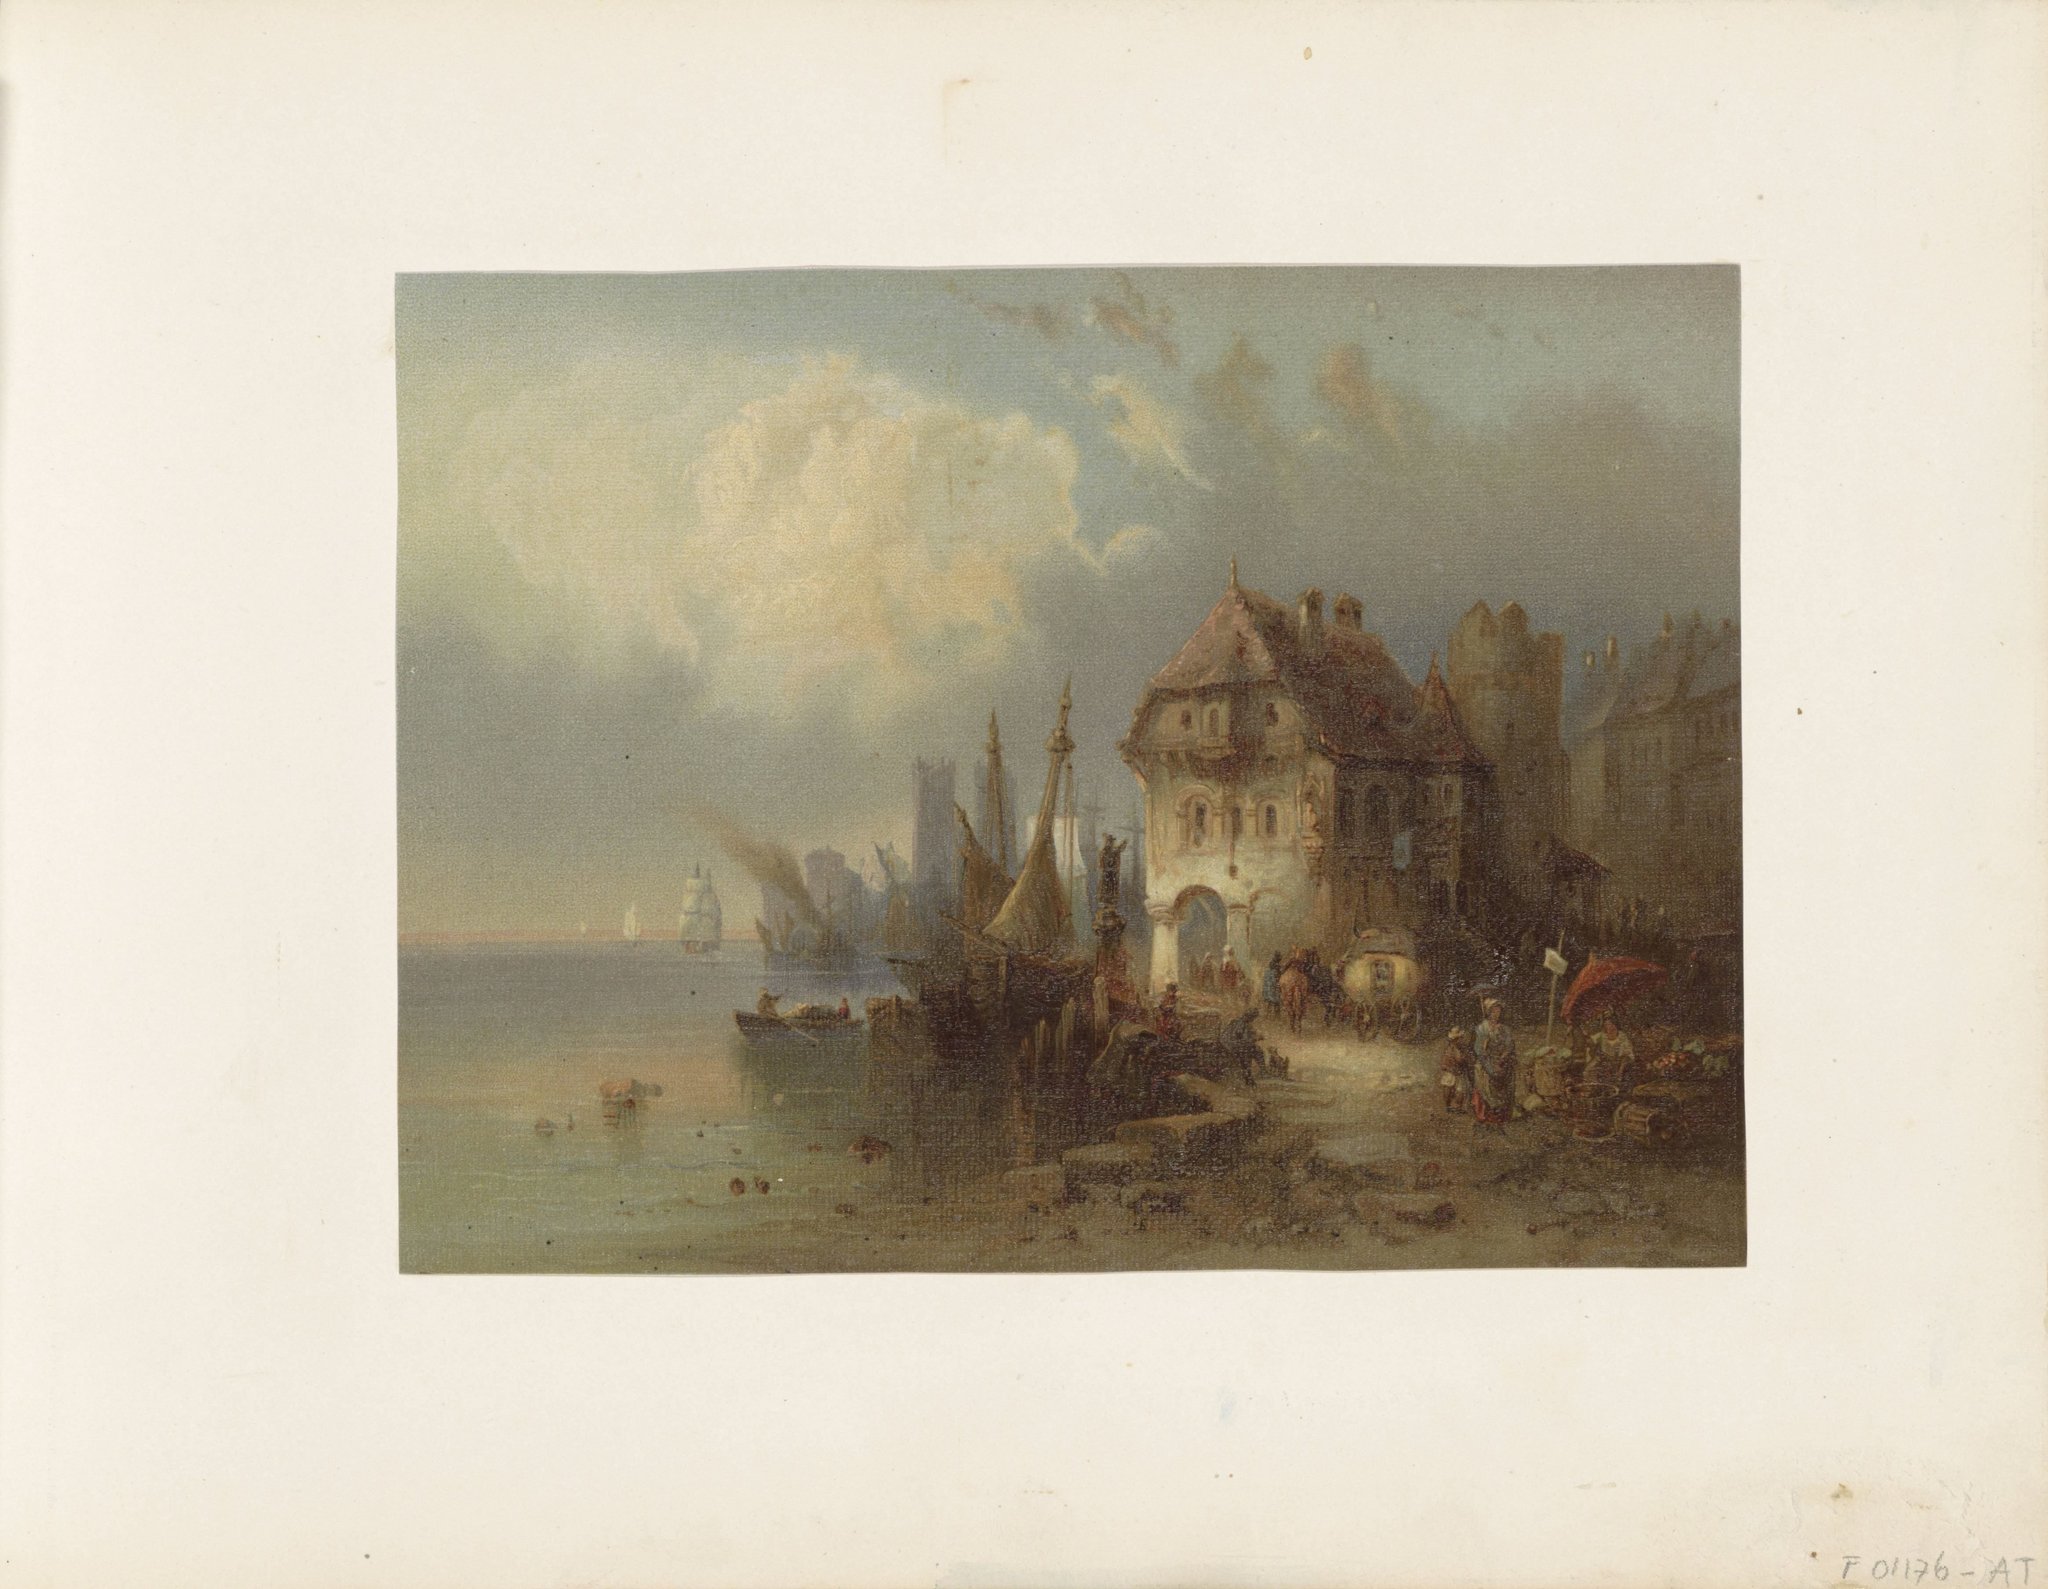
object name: print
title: Havengezicht naar een anoniem schilderij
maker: Anonymous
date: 1850-1876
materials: paper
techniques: chromolithography, oleograph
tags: landscapes with waters, waterscapes, seascapes (in the temperate zone), travelling; tourism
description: Onderdeel van Reisalbum met foto's en tekeningen van Manuel Mayo 1876.